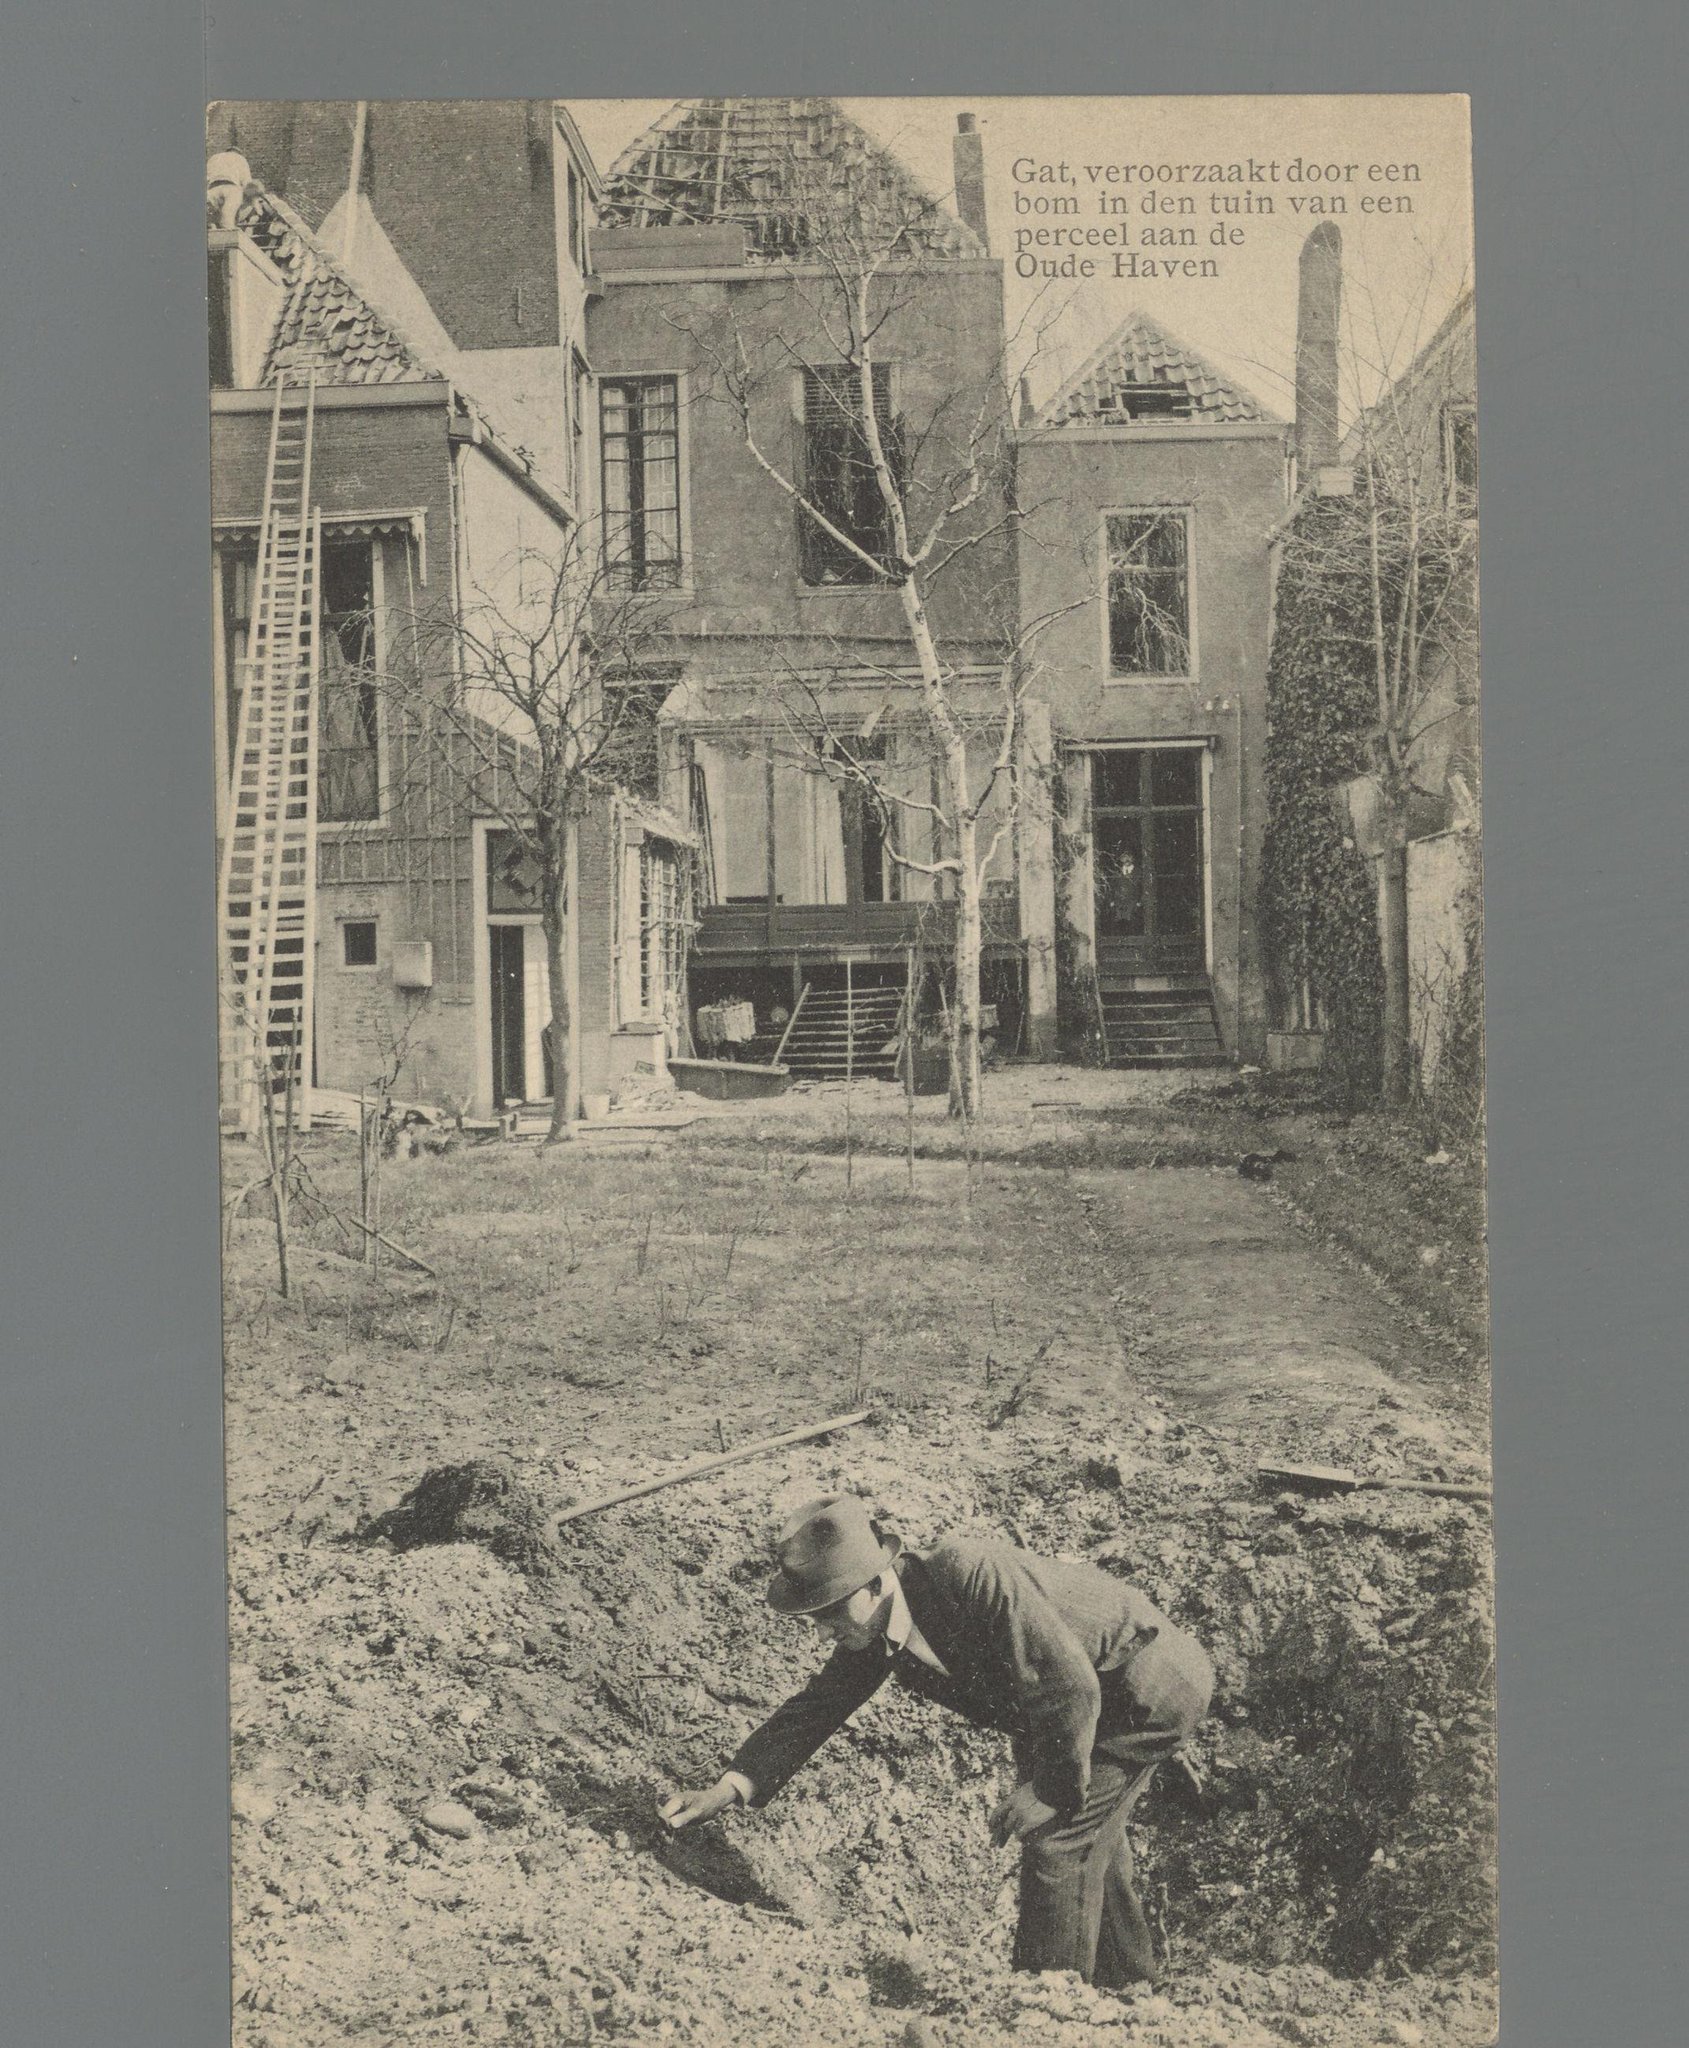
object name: ansichtkaart, prentbriefkaart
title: Gat, veroorzaakt door een bom in den tuin van een perceel aan de Oude Haven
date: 1917-1920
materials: cardboard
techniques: photograph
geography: middelburg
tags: street, bombardment